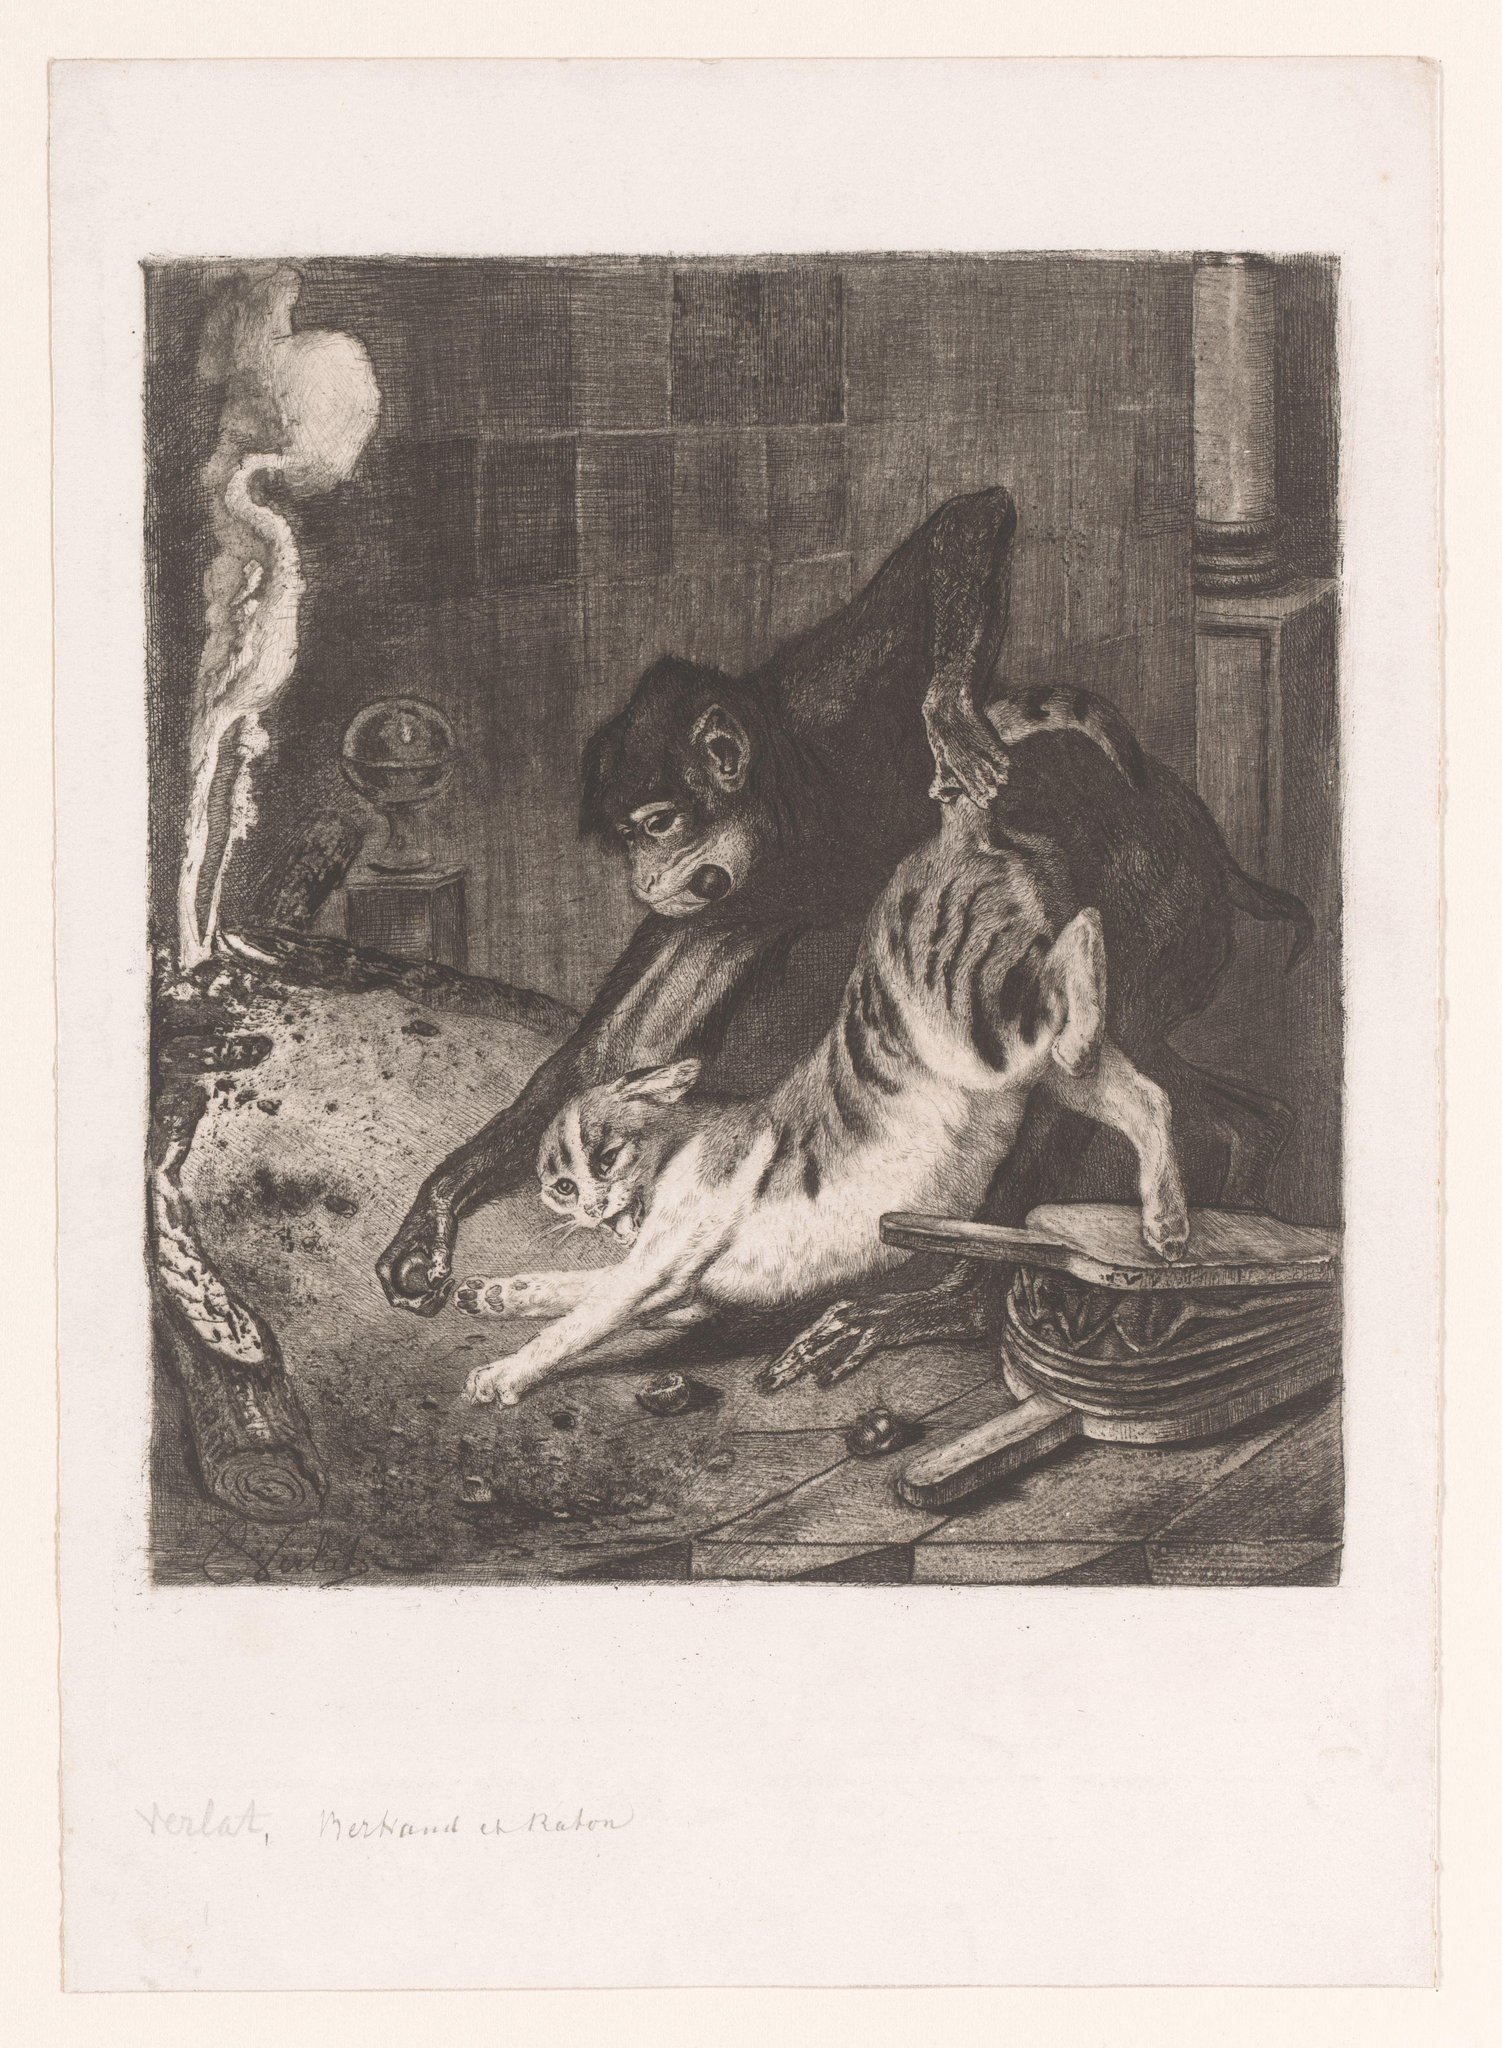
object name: print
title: Aap dwingt een kat de kastanjes uit het vuur te halen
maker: charles verlat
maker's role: painter, print maker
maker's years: 1824-1890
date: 1834-1890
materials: paper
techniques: drypoint, etching, intaglio, retroussage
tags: cat, monkeys, apes, fables, fruits: chestnut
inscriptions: collector's mark: Lugt 2228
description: De aap Bertrand haalt de kat Raton over kastanjes voor hem uit het vuur te halen. Hij belooft hem een deel, maar de aap eet alles zelf op. Fabel van Jean de La Fontaine "De aap en de kat".